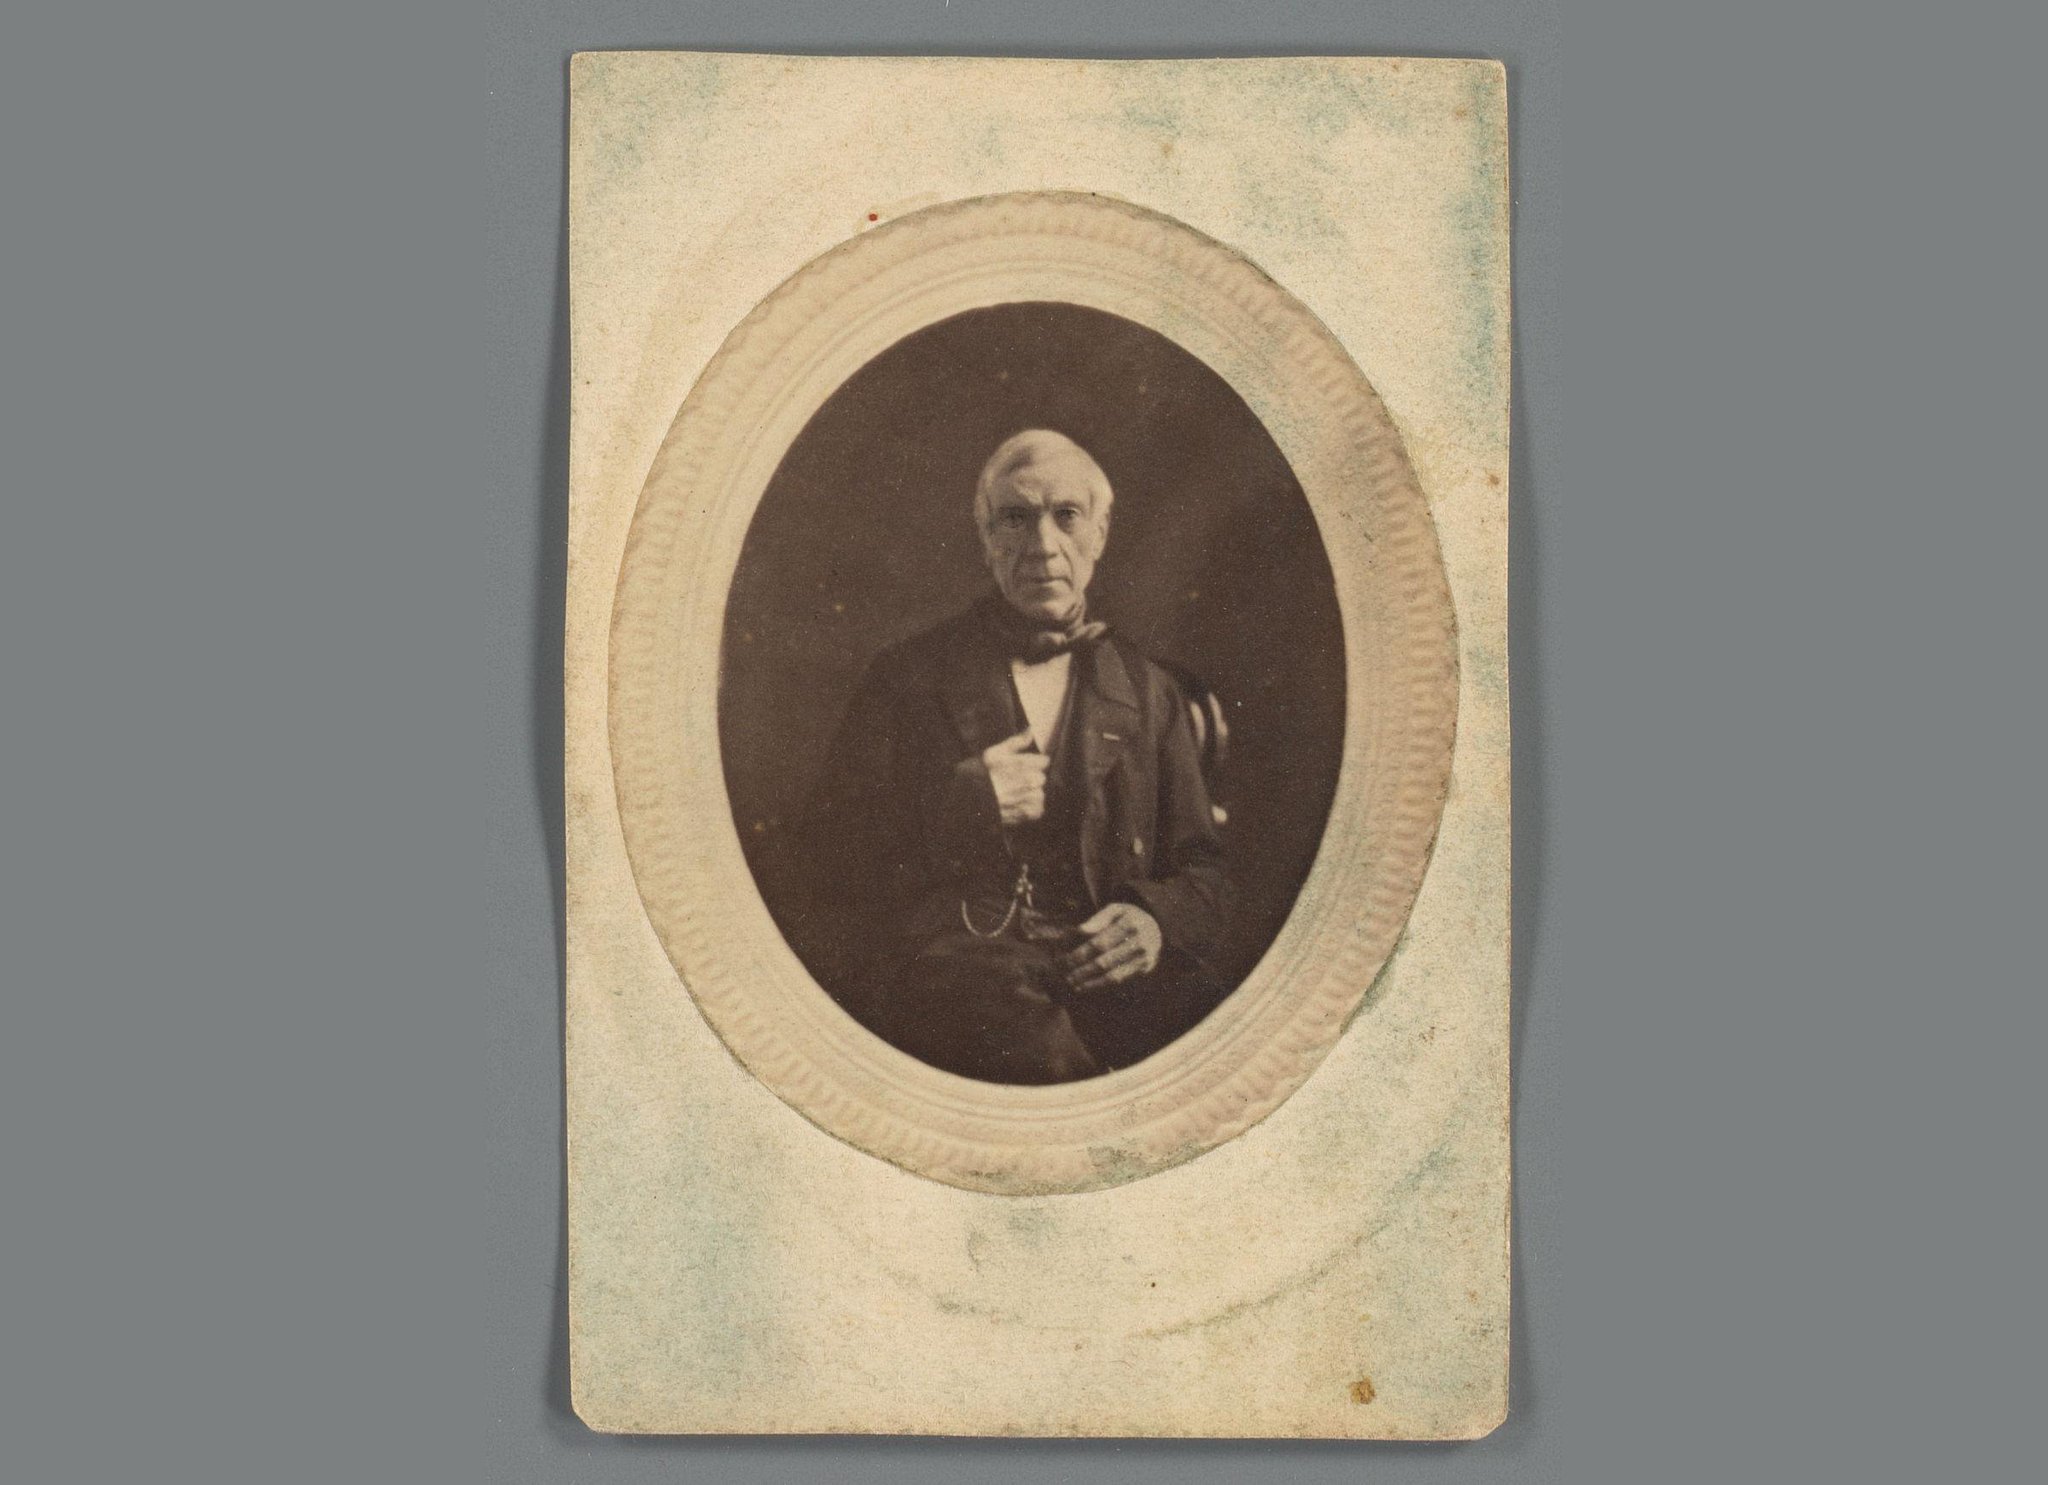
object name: prayer card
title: Portret van Jean Baptiste Bogaerts op bidprent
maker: Anonymous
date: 1860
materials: ink, paper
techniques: albumen print, letterpress printing, pen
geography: antwerp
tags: antwerp, historical persons, old man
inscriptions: inscription: ‘Sa mémoire sera toujours chère (...) Que son âme repose en paix.’